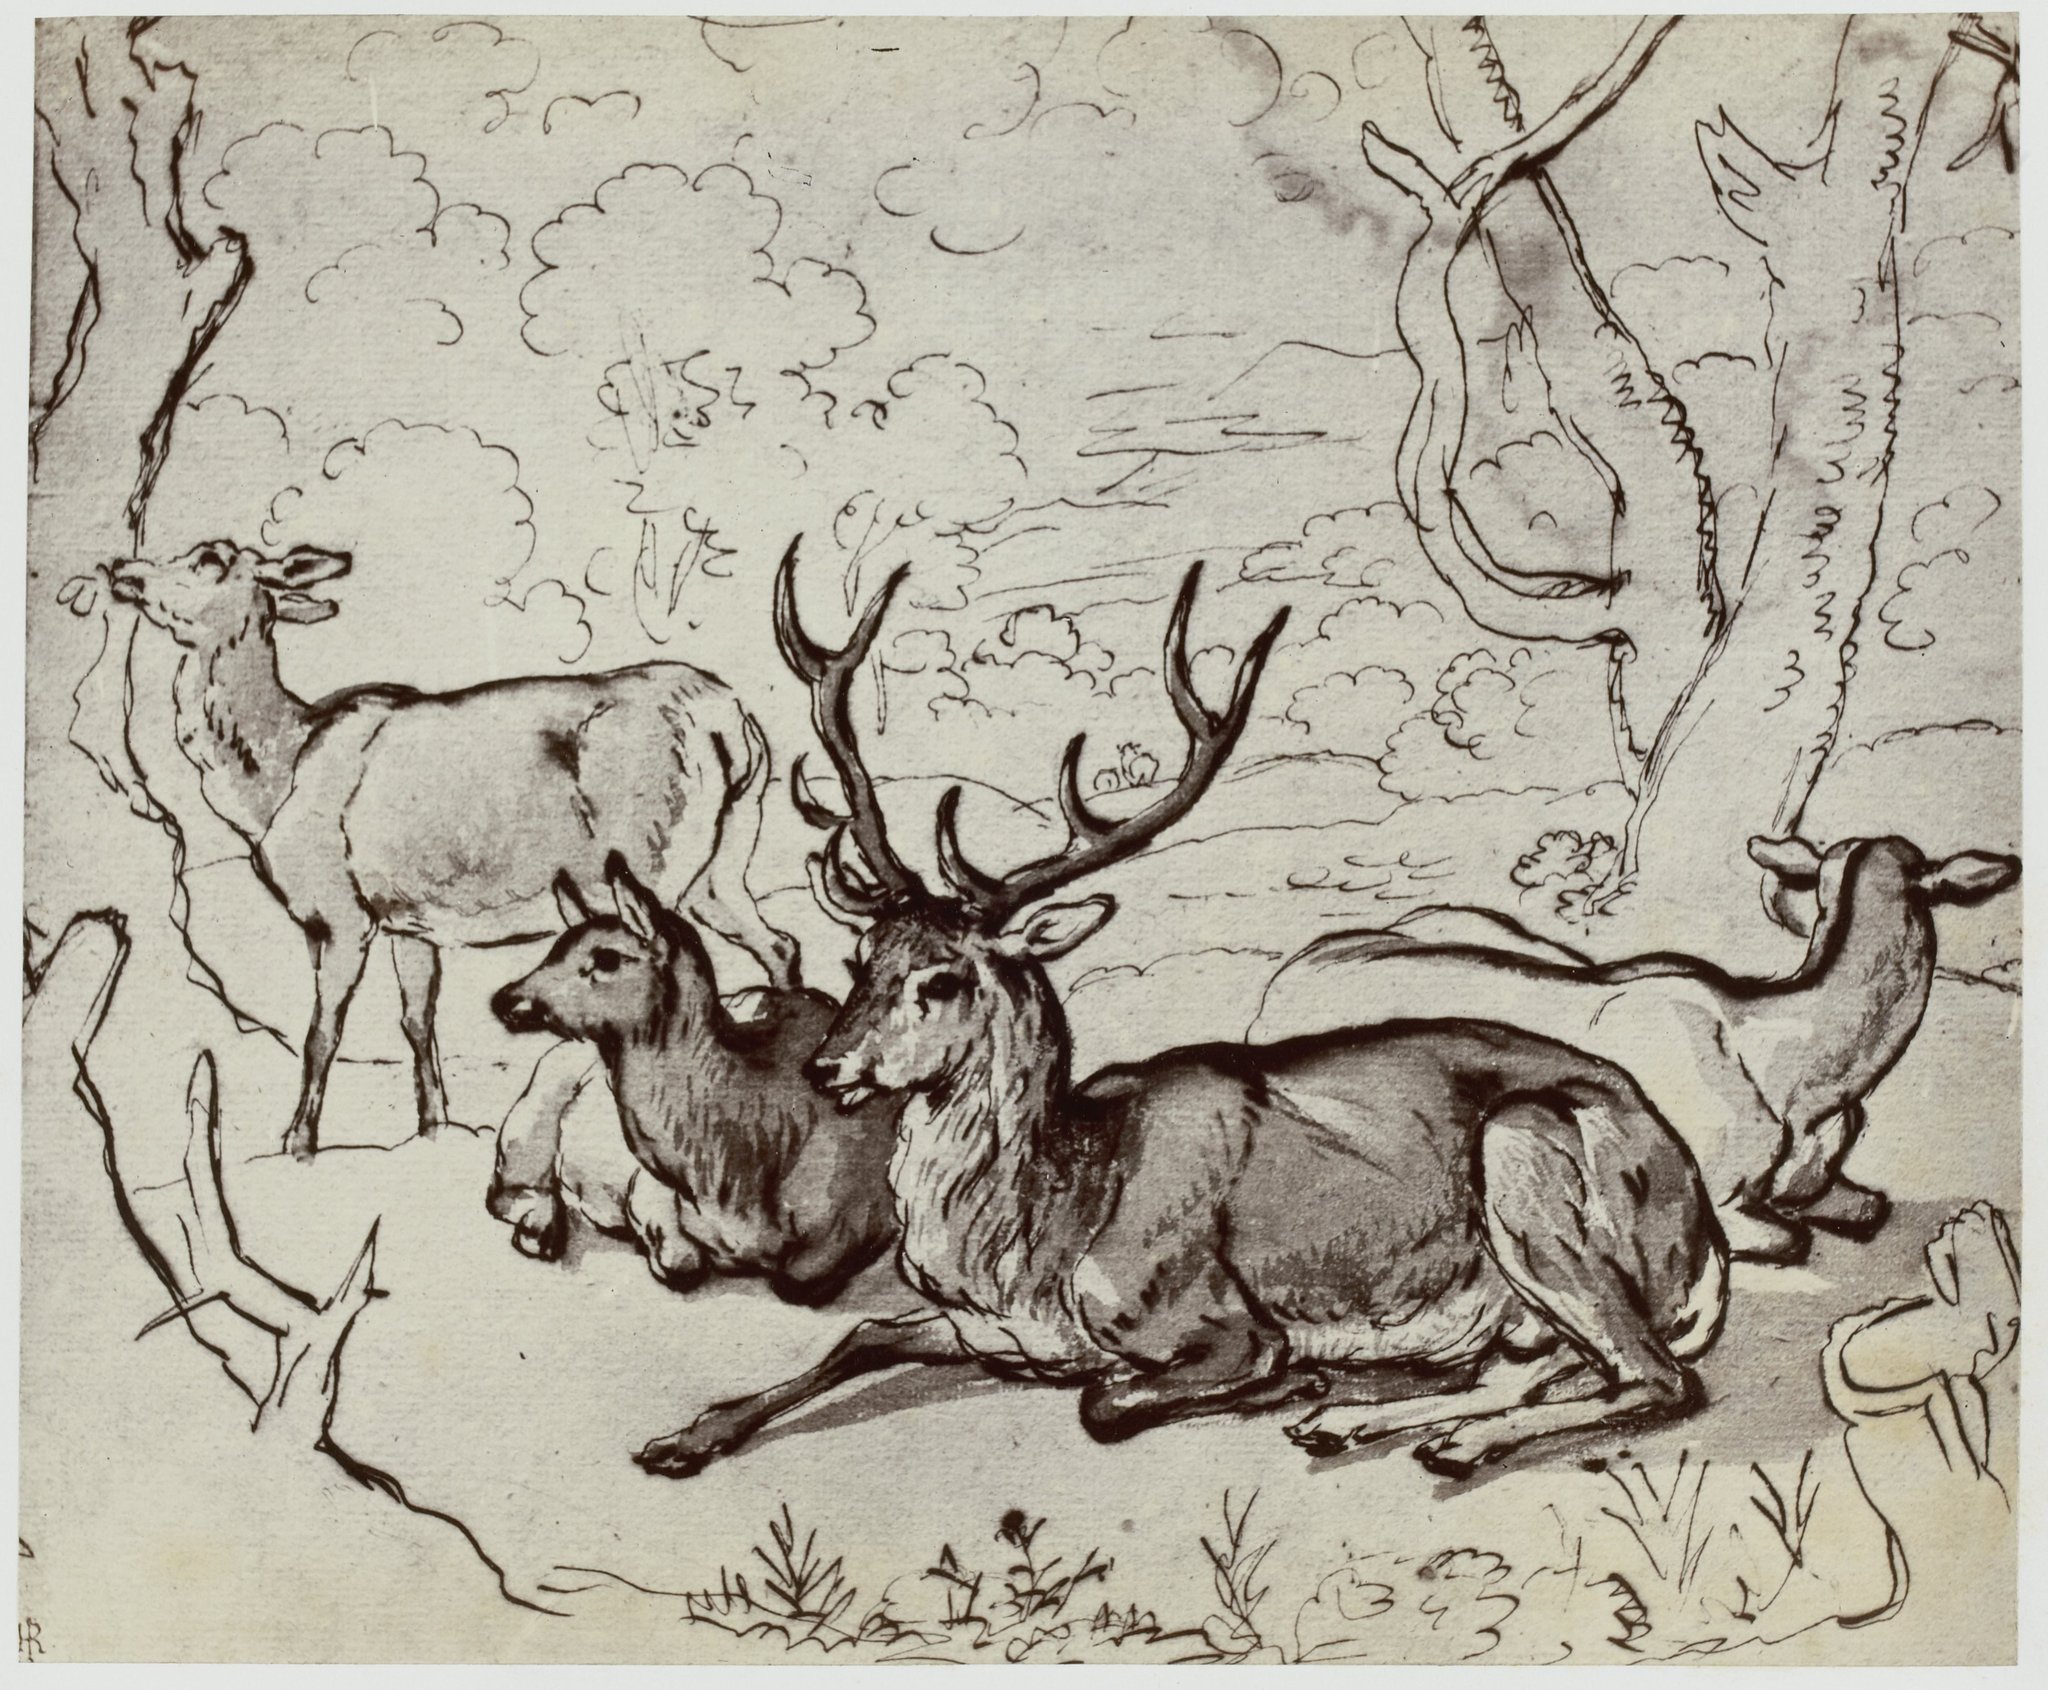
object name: photograph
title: Ridinger, A Deer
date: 1855-1858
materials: cardboard, paper, photographic support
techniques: albumen print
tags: drawing, sketch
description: Fotoreproductie van tekening in 'The Reveley Collection of Drawings at Brynygwin', afb. 21.